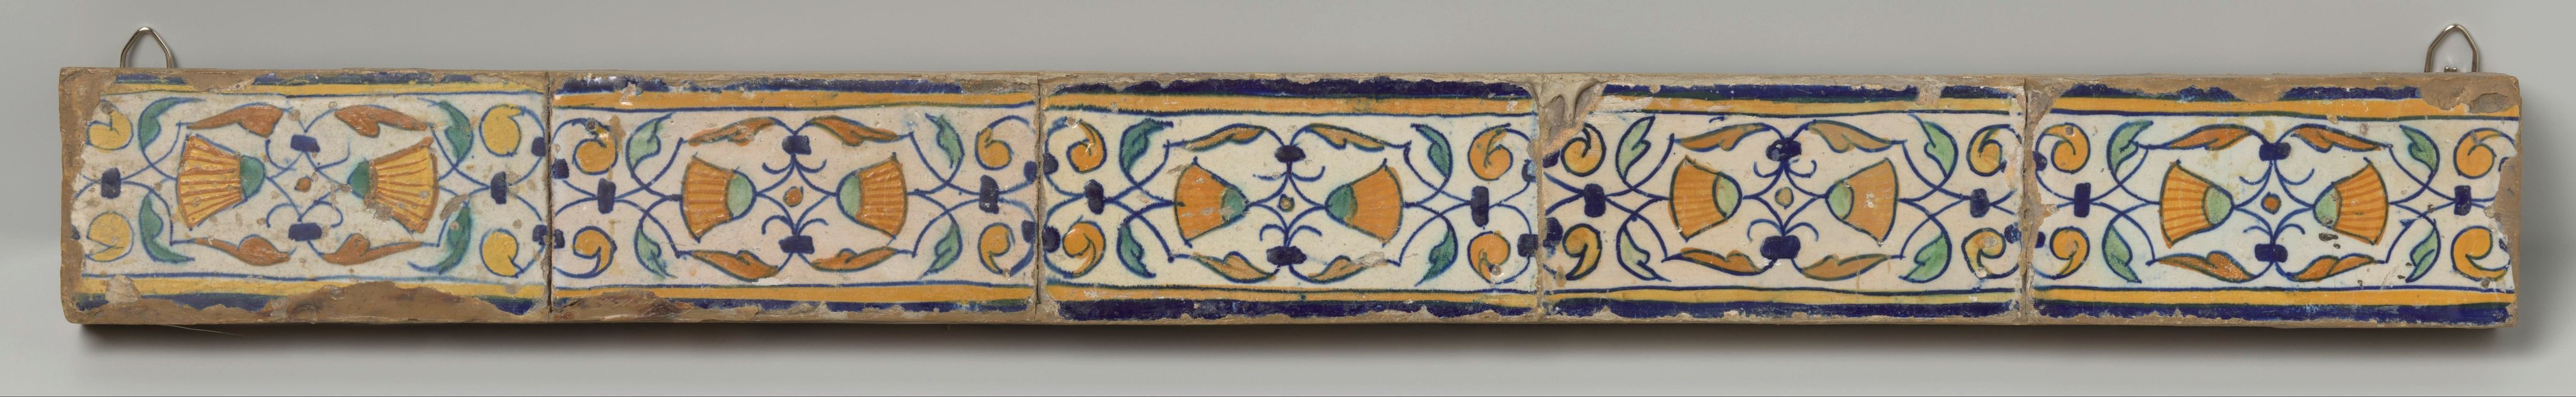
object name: randtegel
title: Veld van vijf randtegels met goudsbloemen en bladeren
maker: Anonymous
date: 1600-1630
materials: earthenware, glaze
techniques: maiolica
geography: netherlands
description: Veld van vijf randtegels (1 x 5) met een veelkleurig (blauw, groen, geel en oranje) ornament van goudsbloemen en bladeren.